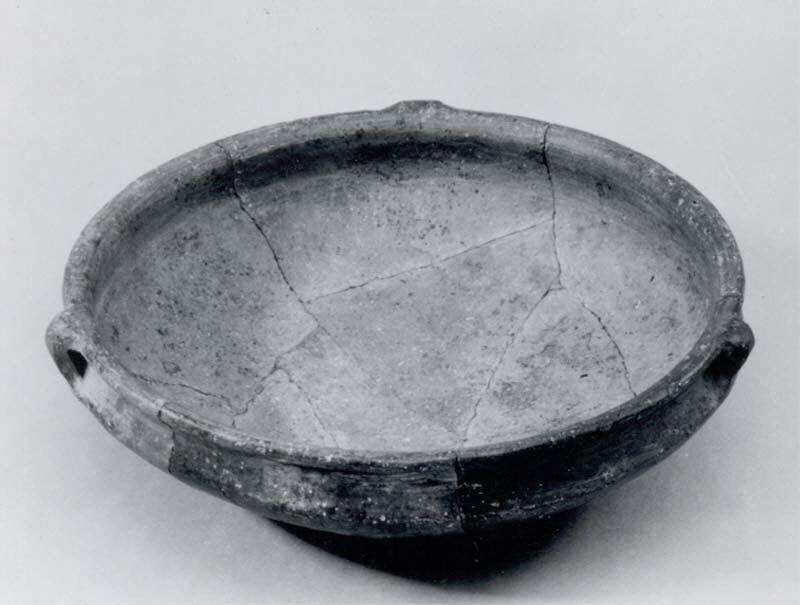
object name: bowl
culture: iranian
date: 900-801 BCE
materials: ceramic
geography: iran